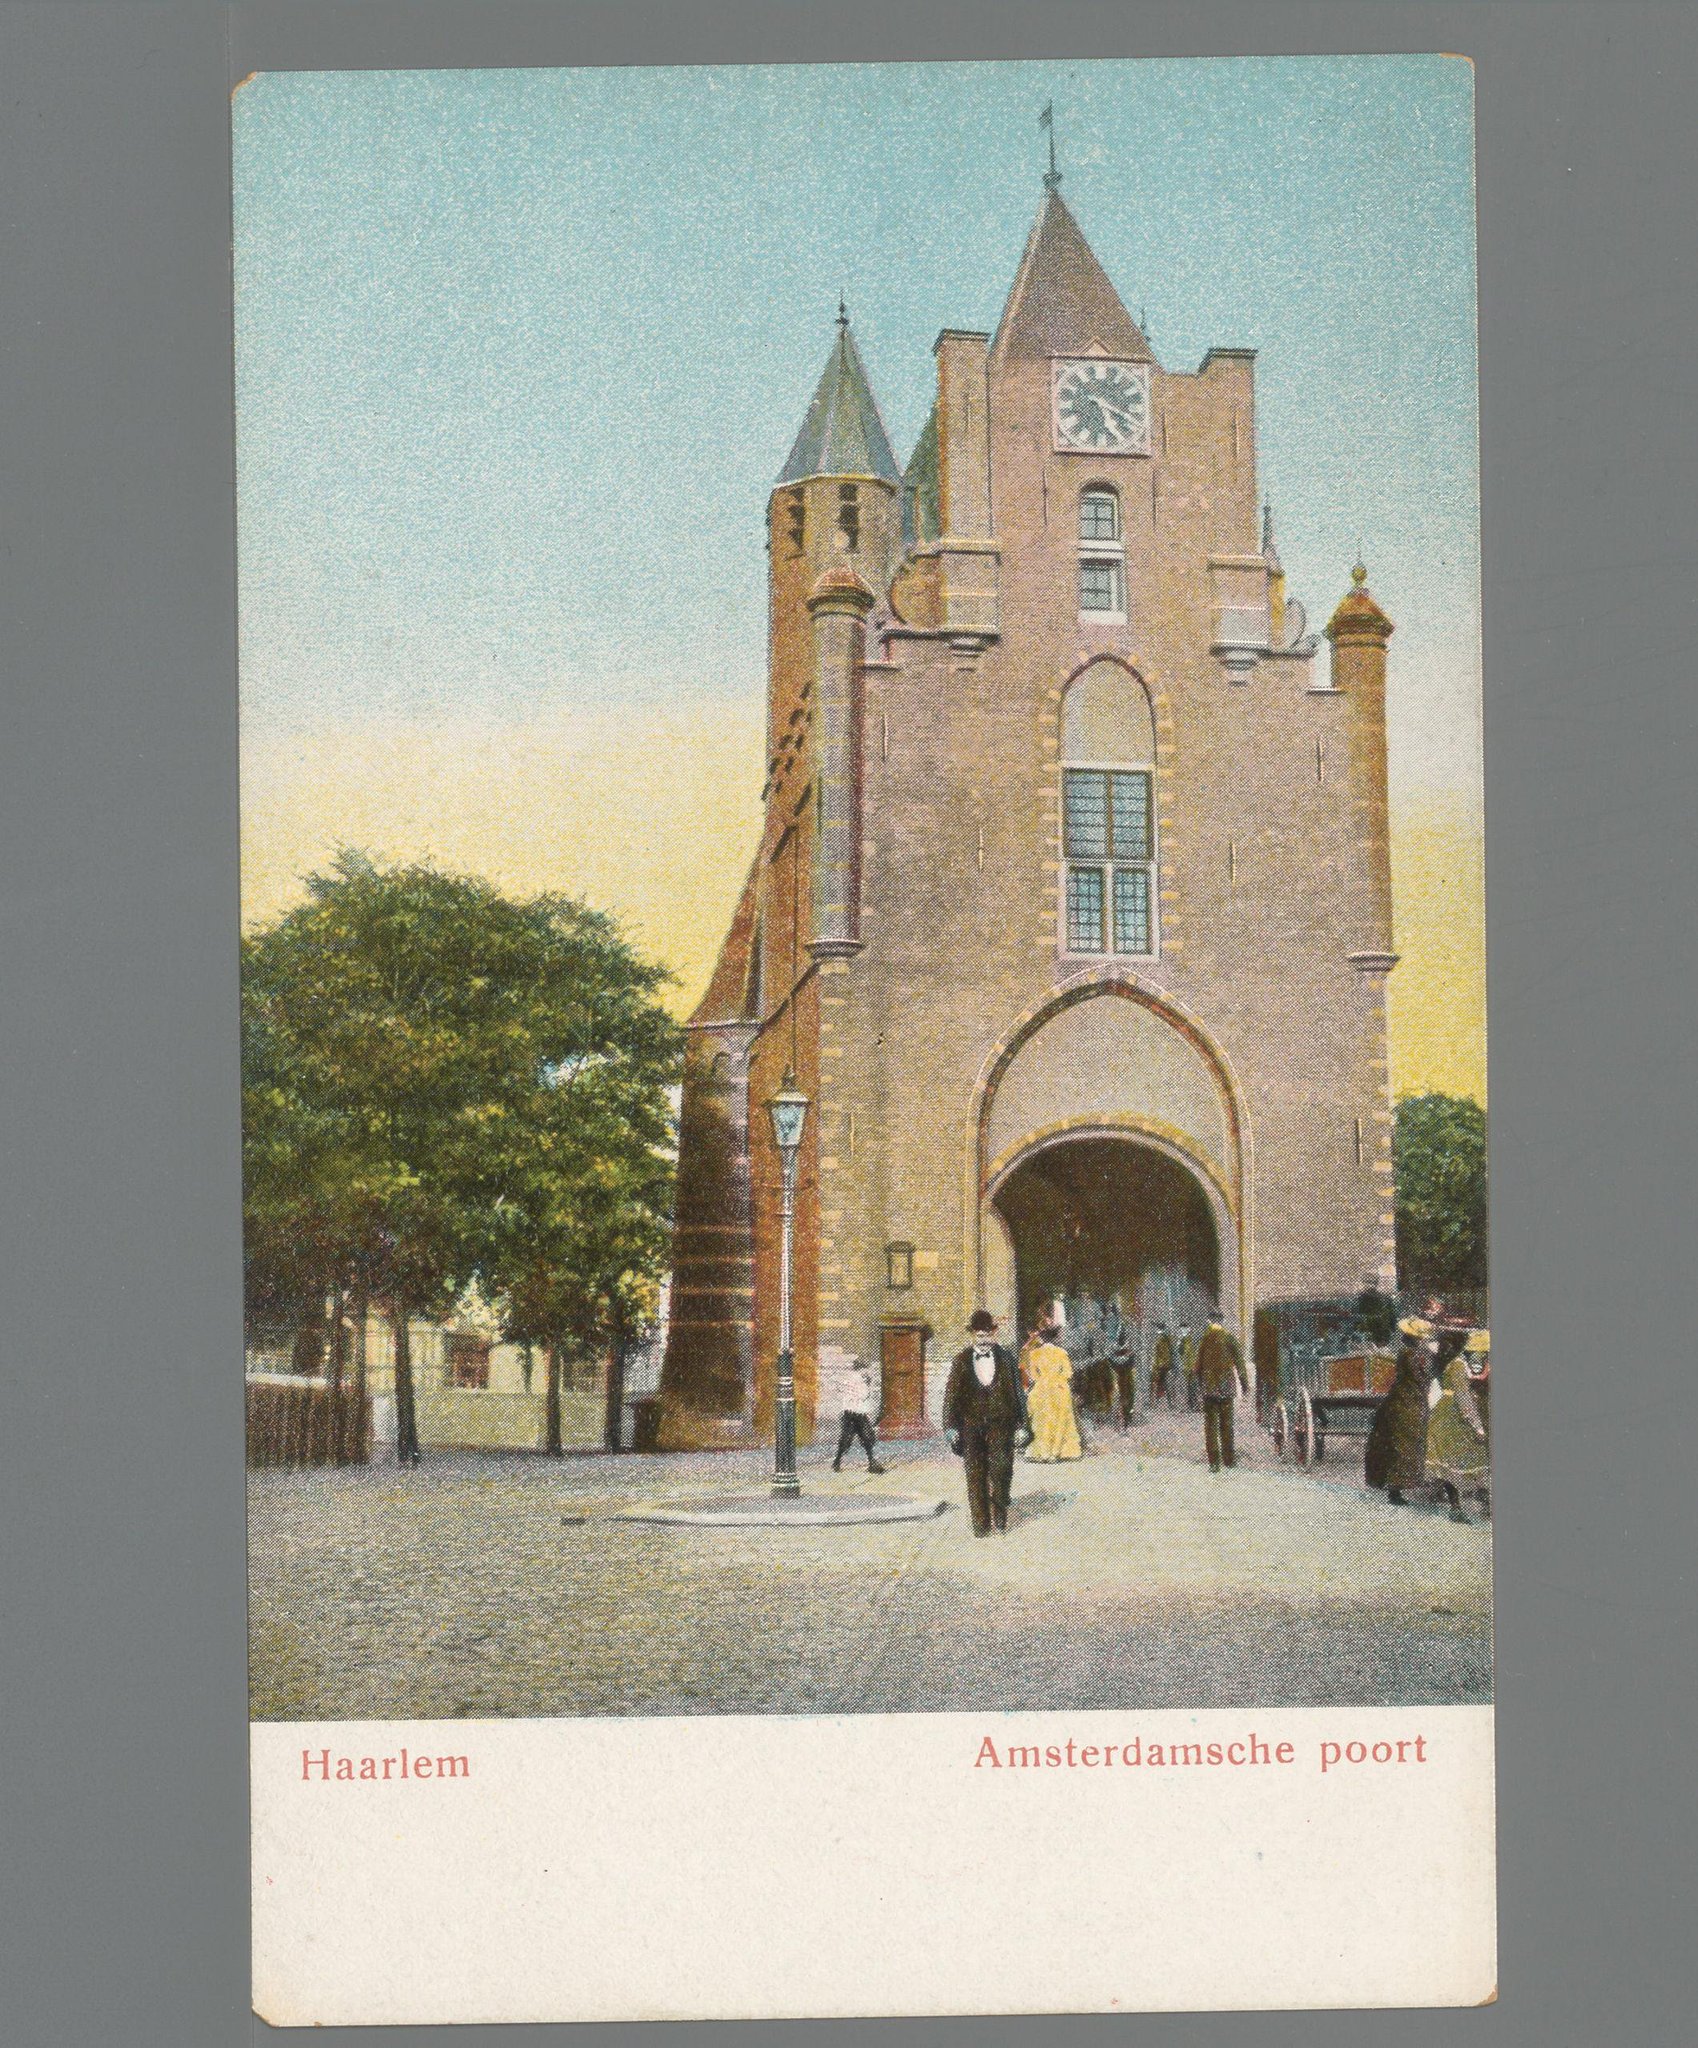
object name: photomechanical print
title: Haarlem. Amsterdamsche poort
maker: Anonymous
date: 1897-1905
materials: cardboard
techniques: lithograph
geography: haarlem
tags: city-gate, haarlem